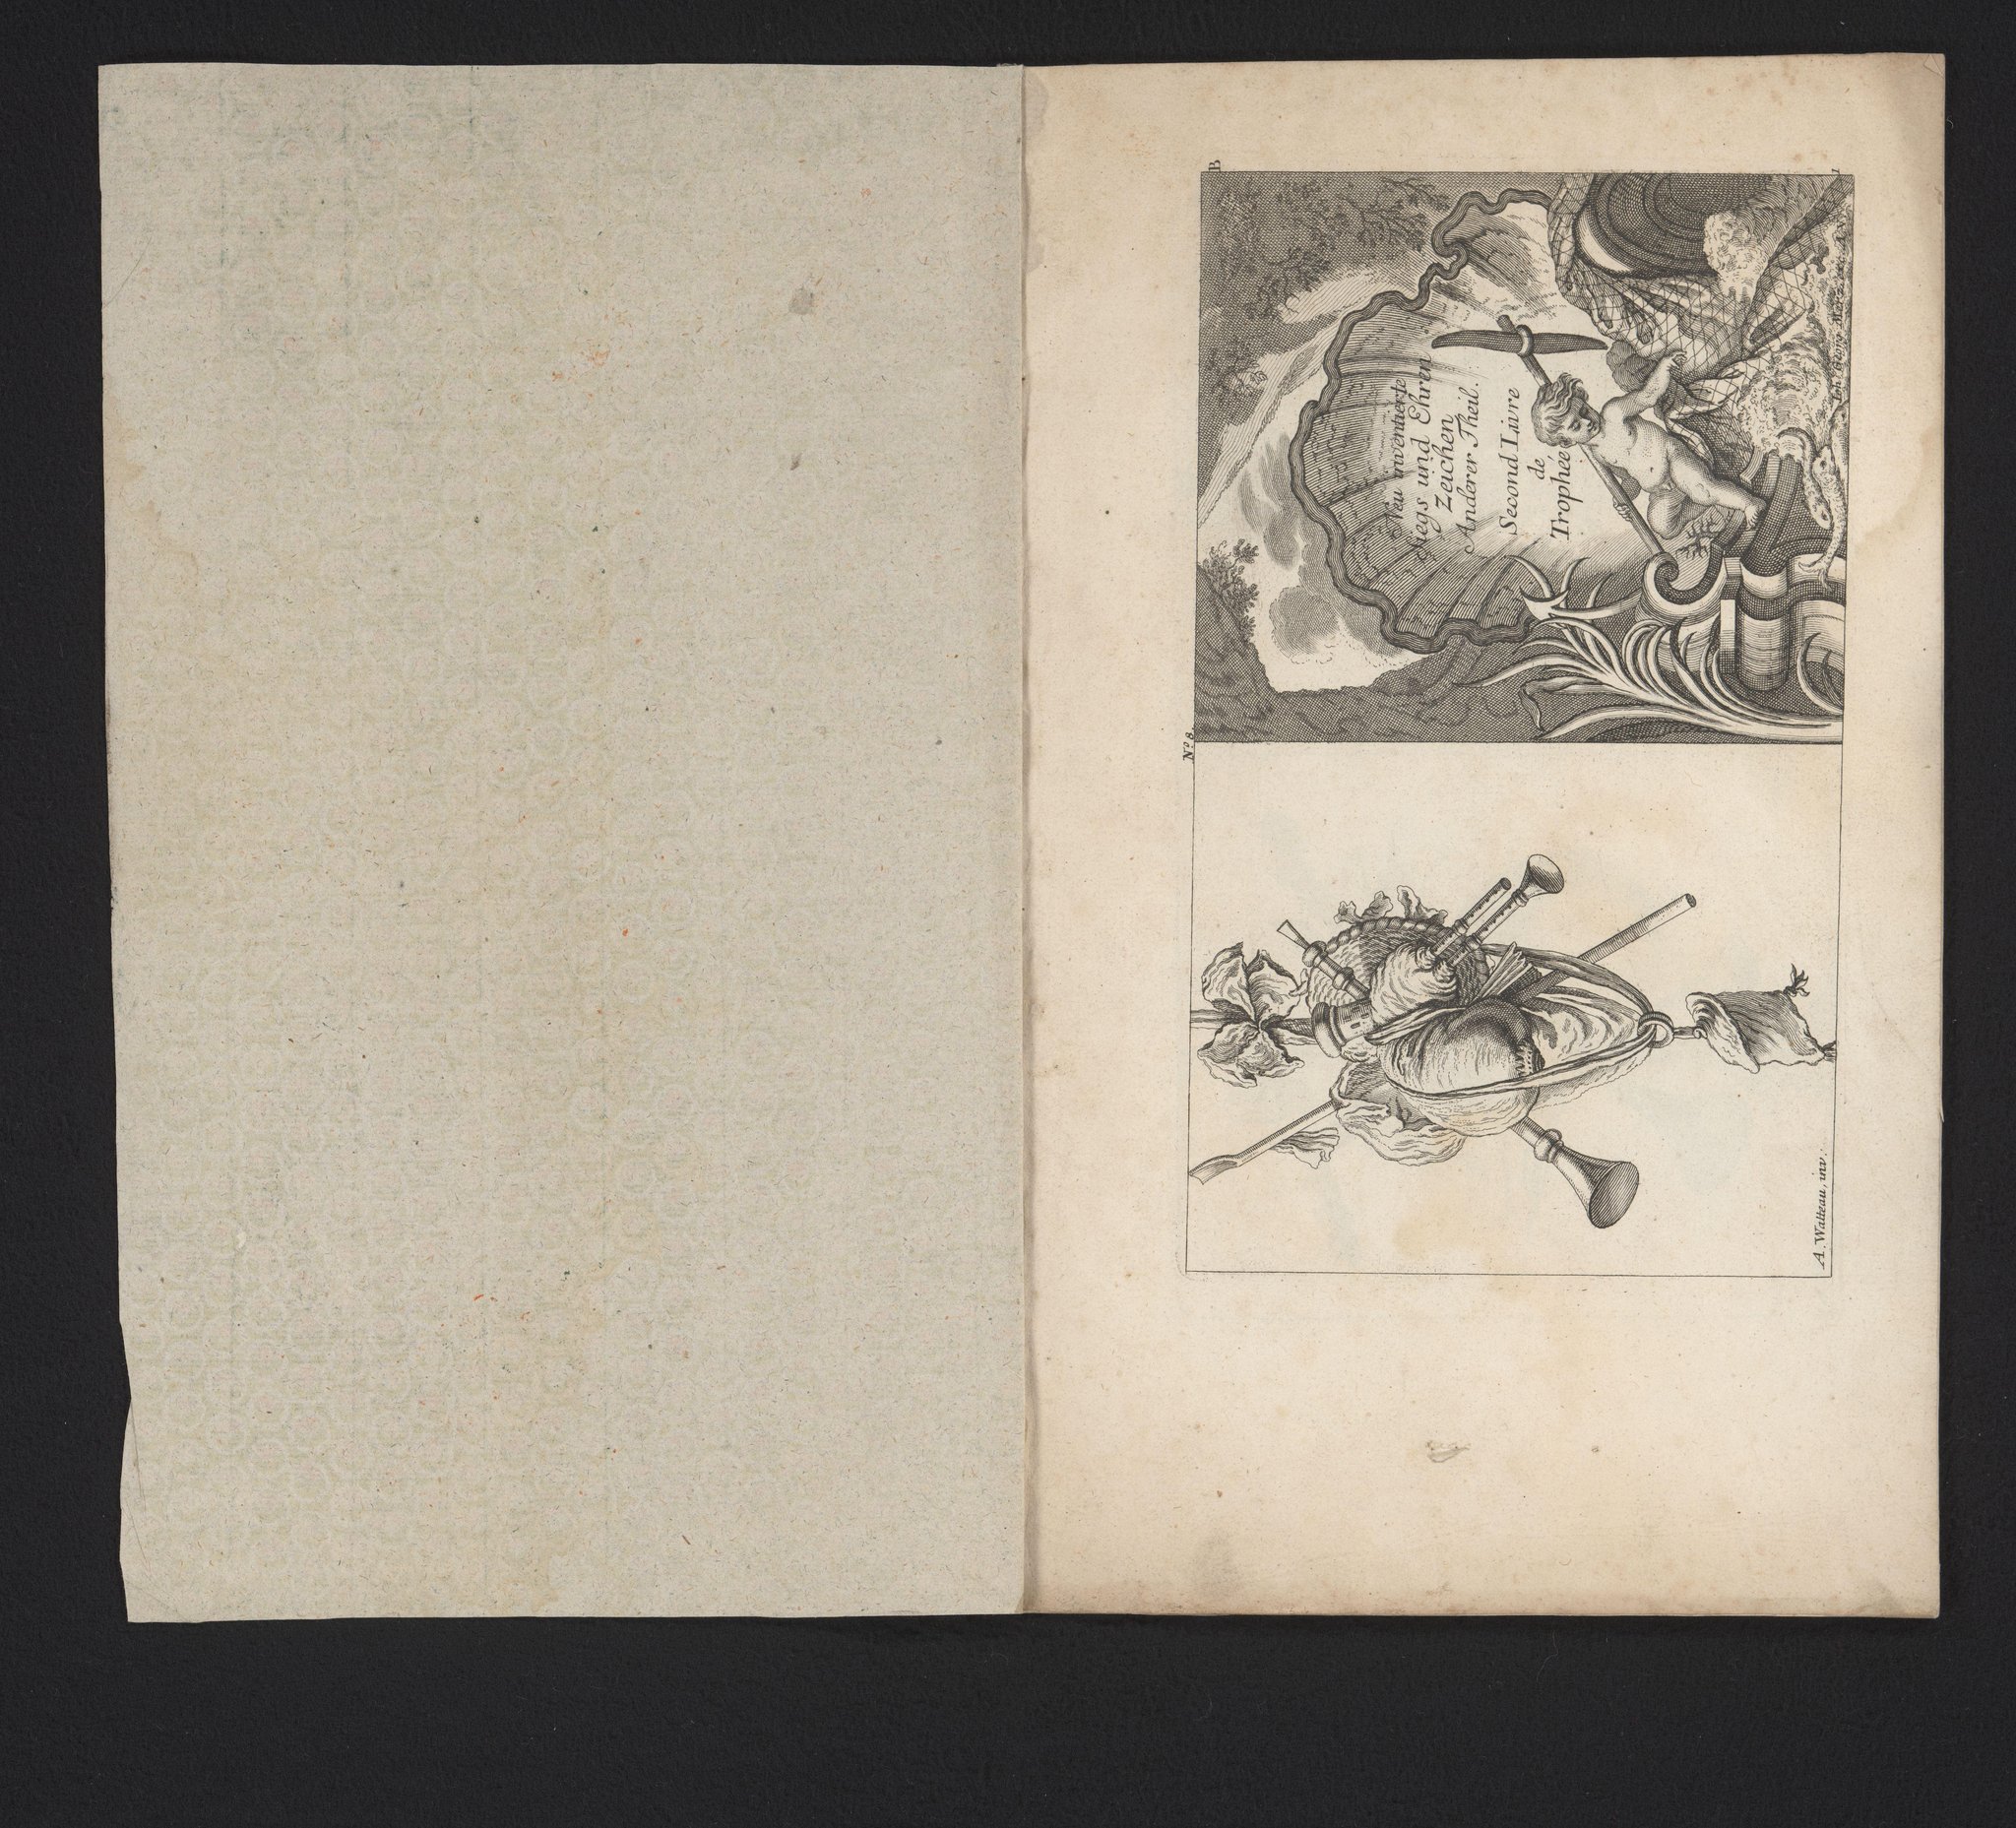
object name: album leaf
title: Trofee met doedelzak en putto zittend voor een schelp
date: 1704-1762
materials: paper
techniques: engraving, etching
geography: augsburg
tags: trophy, i.e.: decorative arrangement of symbolic or typical objects ~ ornament, bagpipe, musette, scallop, shell ~ ornament, cupids: 'amores', 'amoretti', 'putti'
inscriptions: collector's mark: Lugt 2760, collector's mark: Lugt 2228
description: Links een trofee met een doedelzak, fluiten, een tas en een herdersstaf. Rechts zit een putto op een ornament met water en vissen, achter hem een schelp met de serietitel. Uitgeversnummer 8. Rechts boven B genummerd. Prent maakt deel uit van een album met een serie van zes trofeeën.